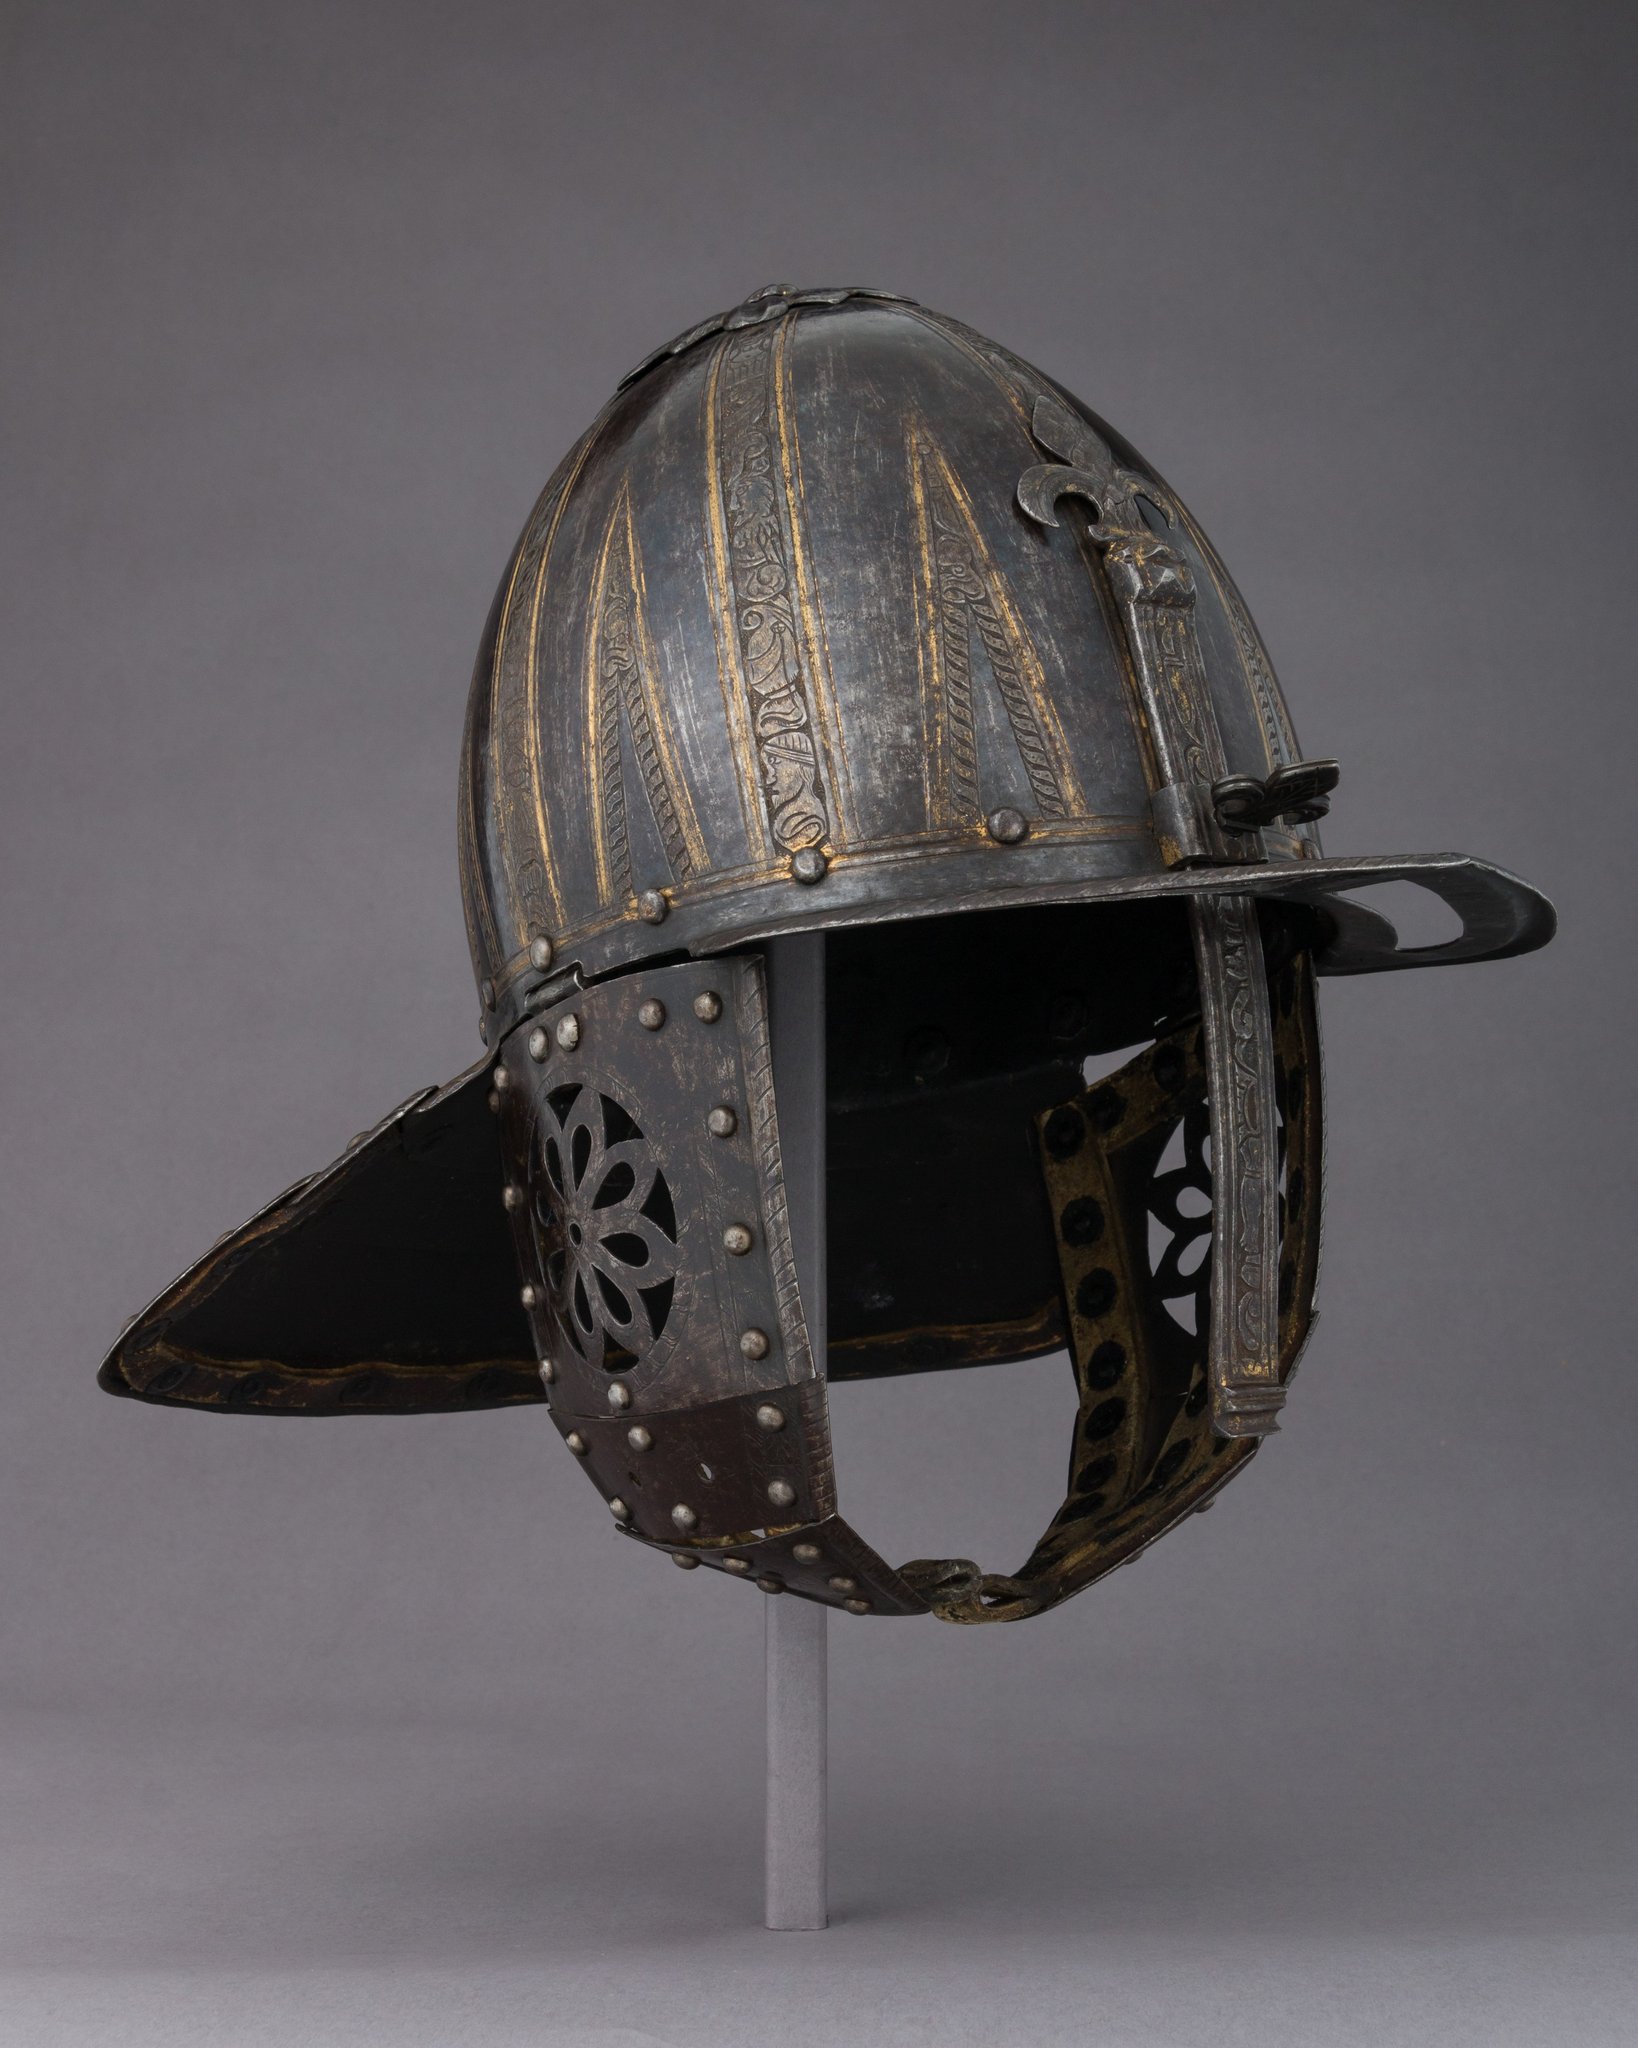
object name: lobster tail burgonet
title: Lobster-Tail Burgonet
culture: north italian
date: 1610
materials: gold, leather, steel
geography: northern italy